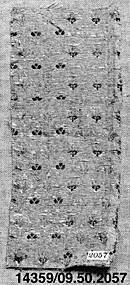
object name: textile fragment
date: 1701-1800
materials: metal thread, silk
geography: india